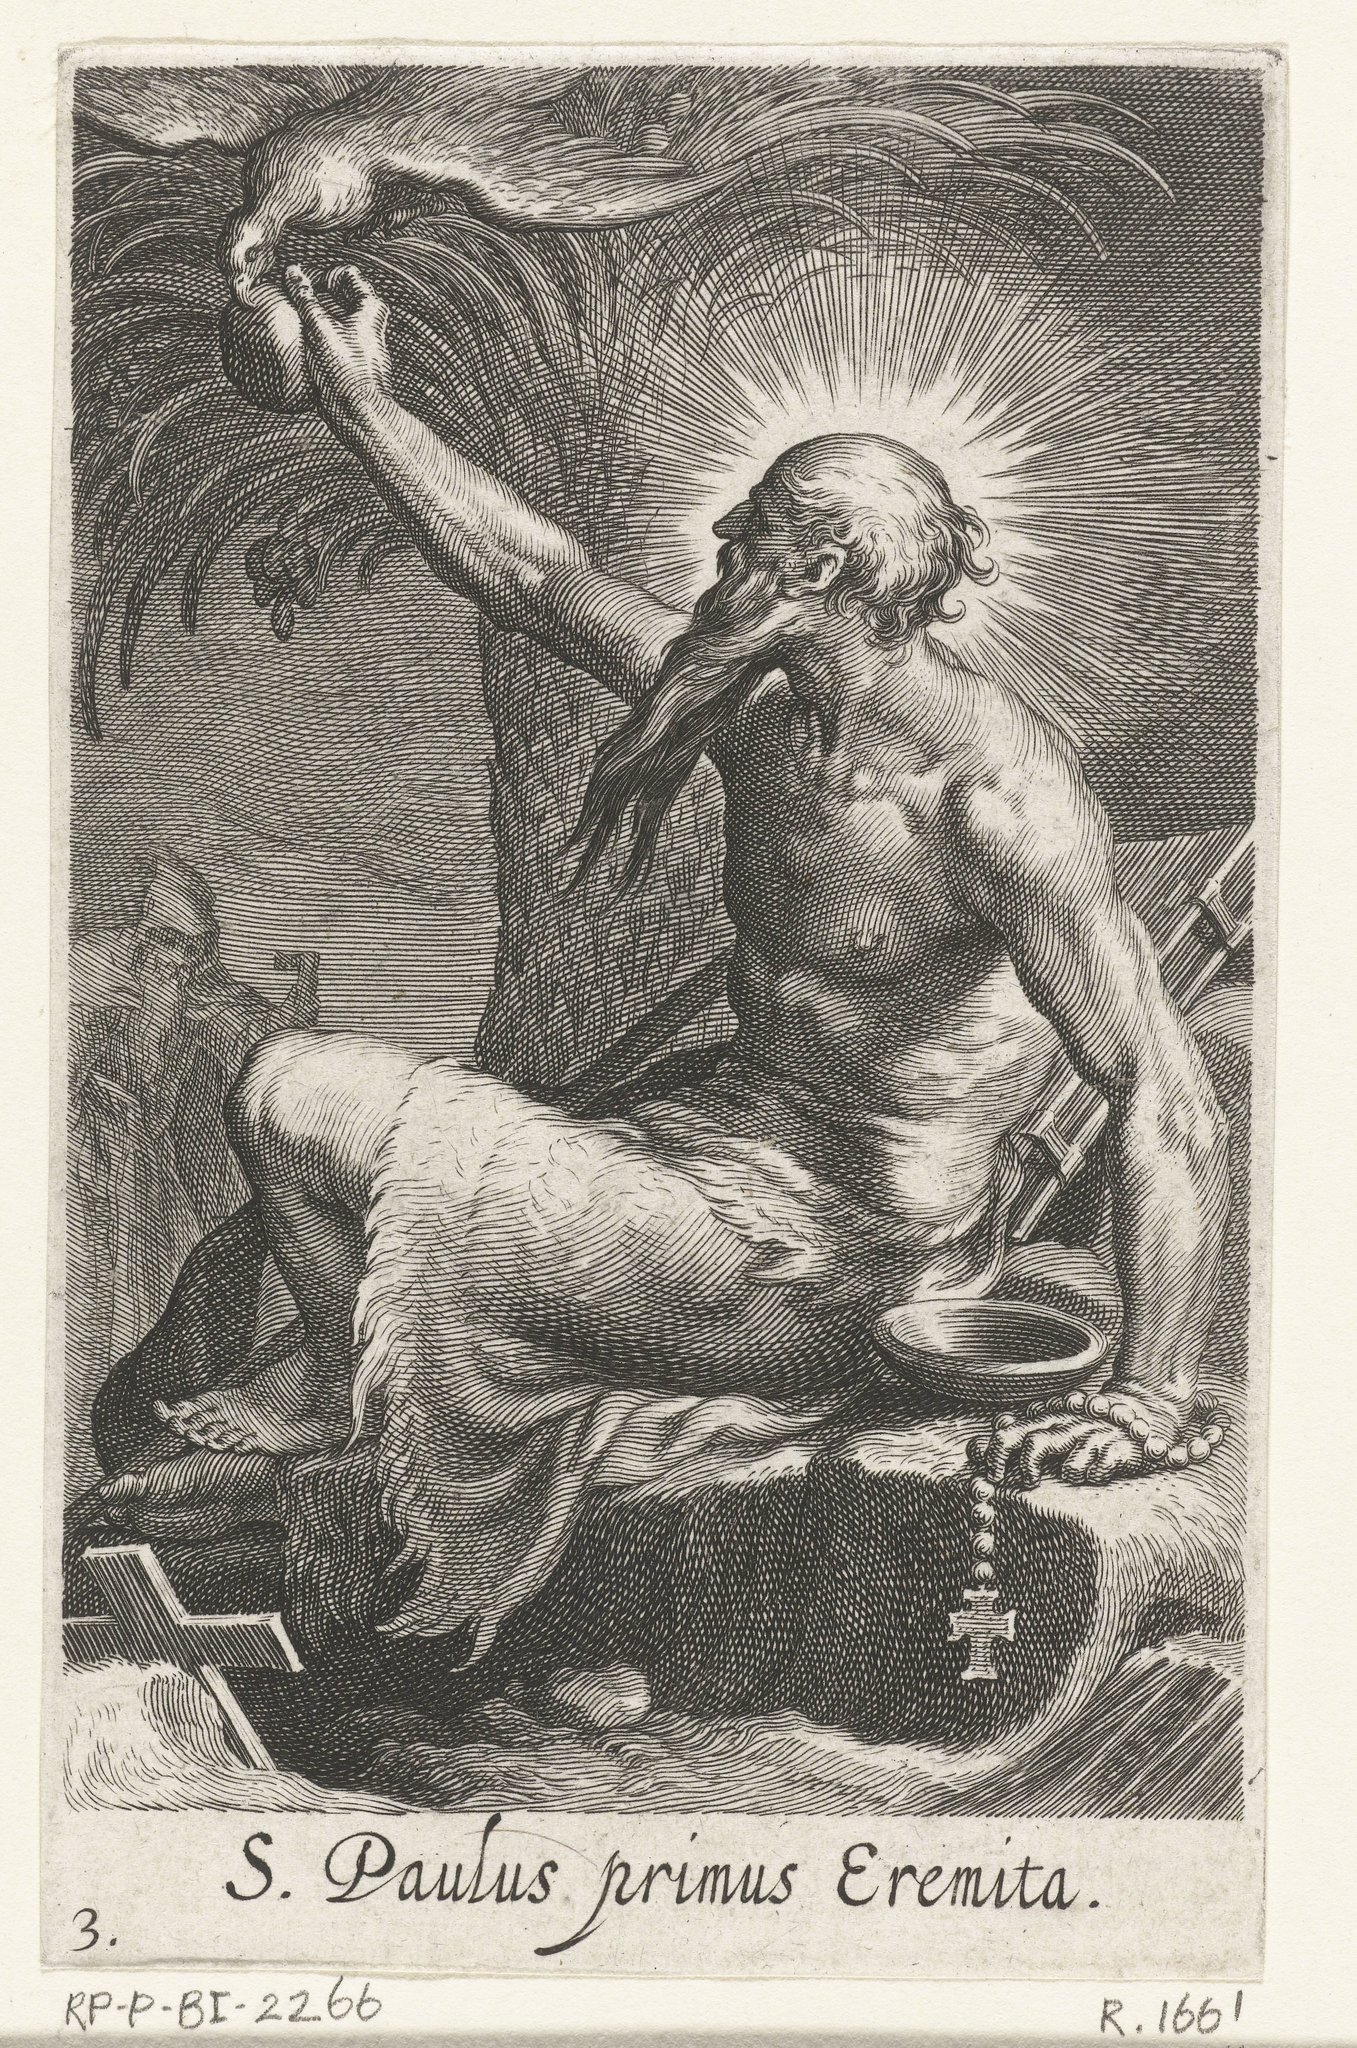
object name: print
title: Heilige Paulus van Thebe als kluizenaar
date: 1590-1612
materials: paper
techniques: engraving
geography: antwerp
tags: paul of thebes, the first hermit; possible attributes: raven, two lions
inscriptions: collector's mark: Lugt 240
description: Prent uit: Sacra eremus ascetarum, Antwerpen, Hendrick Aertssen, 1619. Eerste gebonden uitgave met in totaal vijftig prenten. Prent uit serie van vijfentwintig mannelijke kluizenaars. In 1612 verscheen een ongebonden editie maar op basis van de gewijzigde opschriften en samenstelling wordt aangenomen dat de prenten van de uitgave 1619 ook in 1612 of iets daarvoor gedrukt werden. Roethlisberger beschouwt de uitgave van 1619 als de eerste staat en de ongebonden editie van 1612 als de tweede staat (Roethlisberger 1993, p. 171, 172).